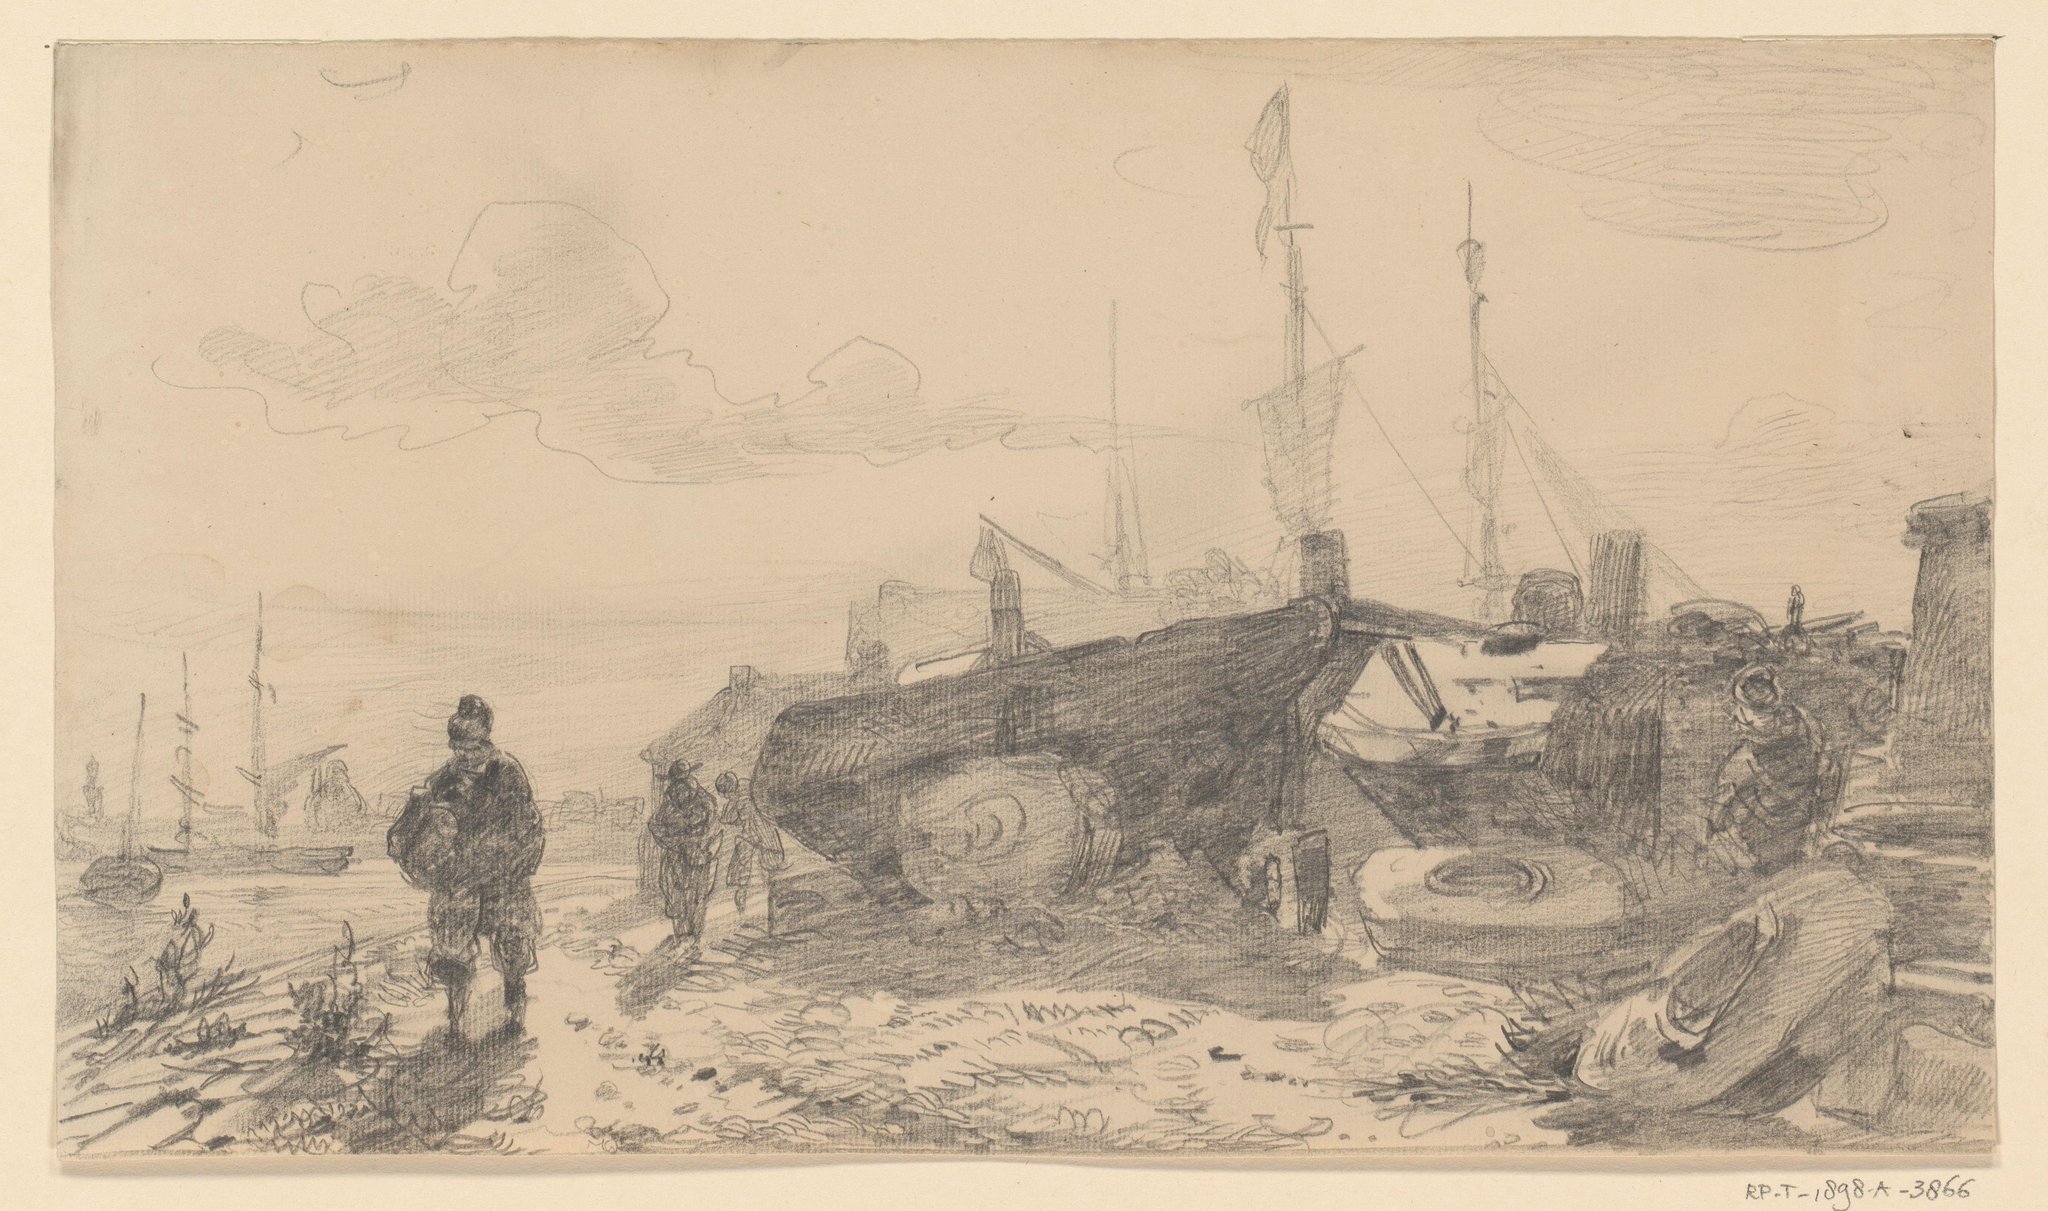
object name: drawing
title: Figuren op oever bij scheepswerf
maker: willem anthonie van deventer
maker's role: draughtsman, painter, print maker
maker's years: 1824-1893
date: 1834-1893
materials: paper, pencil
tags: shipyard, shipdock